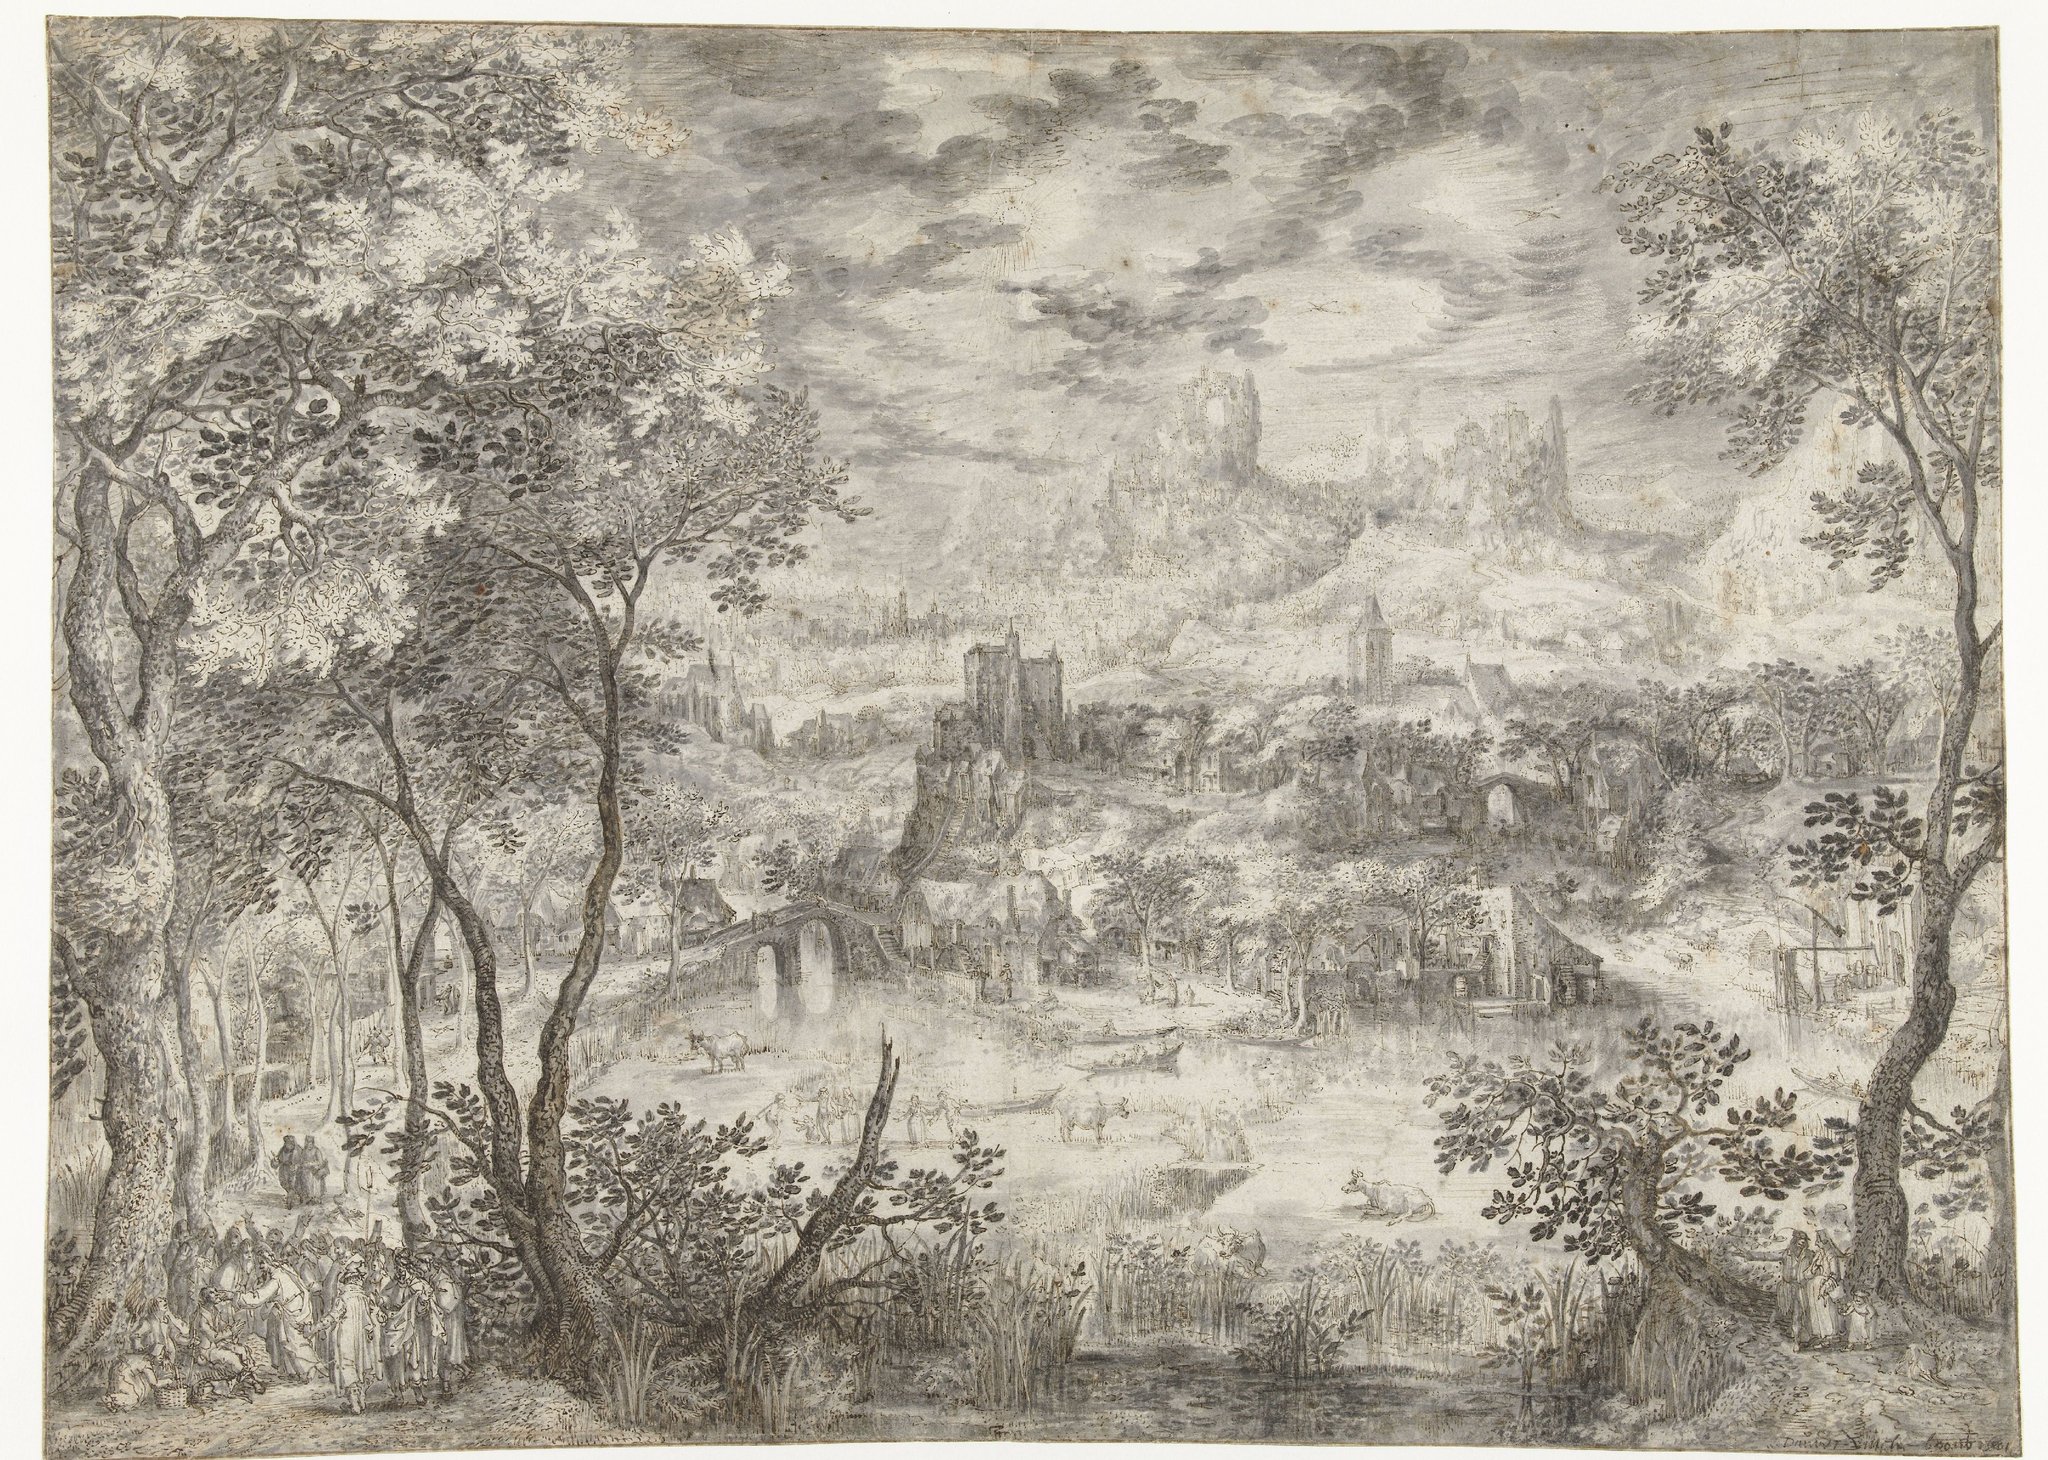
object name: drawing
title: Landscape with the Healing of the Blind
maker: david vinckboons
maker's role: draughtsman, painter, print maker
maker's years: 1576-1629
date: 1601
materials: ink, paper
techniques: brush, pen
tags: healing of a man born blind: christ touches his eyes with an 'ointment' of dust and spittle (john 9), (high) hill, forest, wood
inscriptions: date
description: The miracle takes place in the left foreground, in just a few square centimetres. Jesus heals a blind man by brushing his eyes with spittle mixed with dirt and commanding him to wash himself. The drawing, which is part of a series of landscapes with scenes from the Bible, is dated 1601. Vinckboons thus made it when he was only 24 or 25 years old.